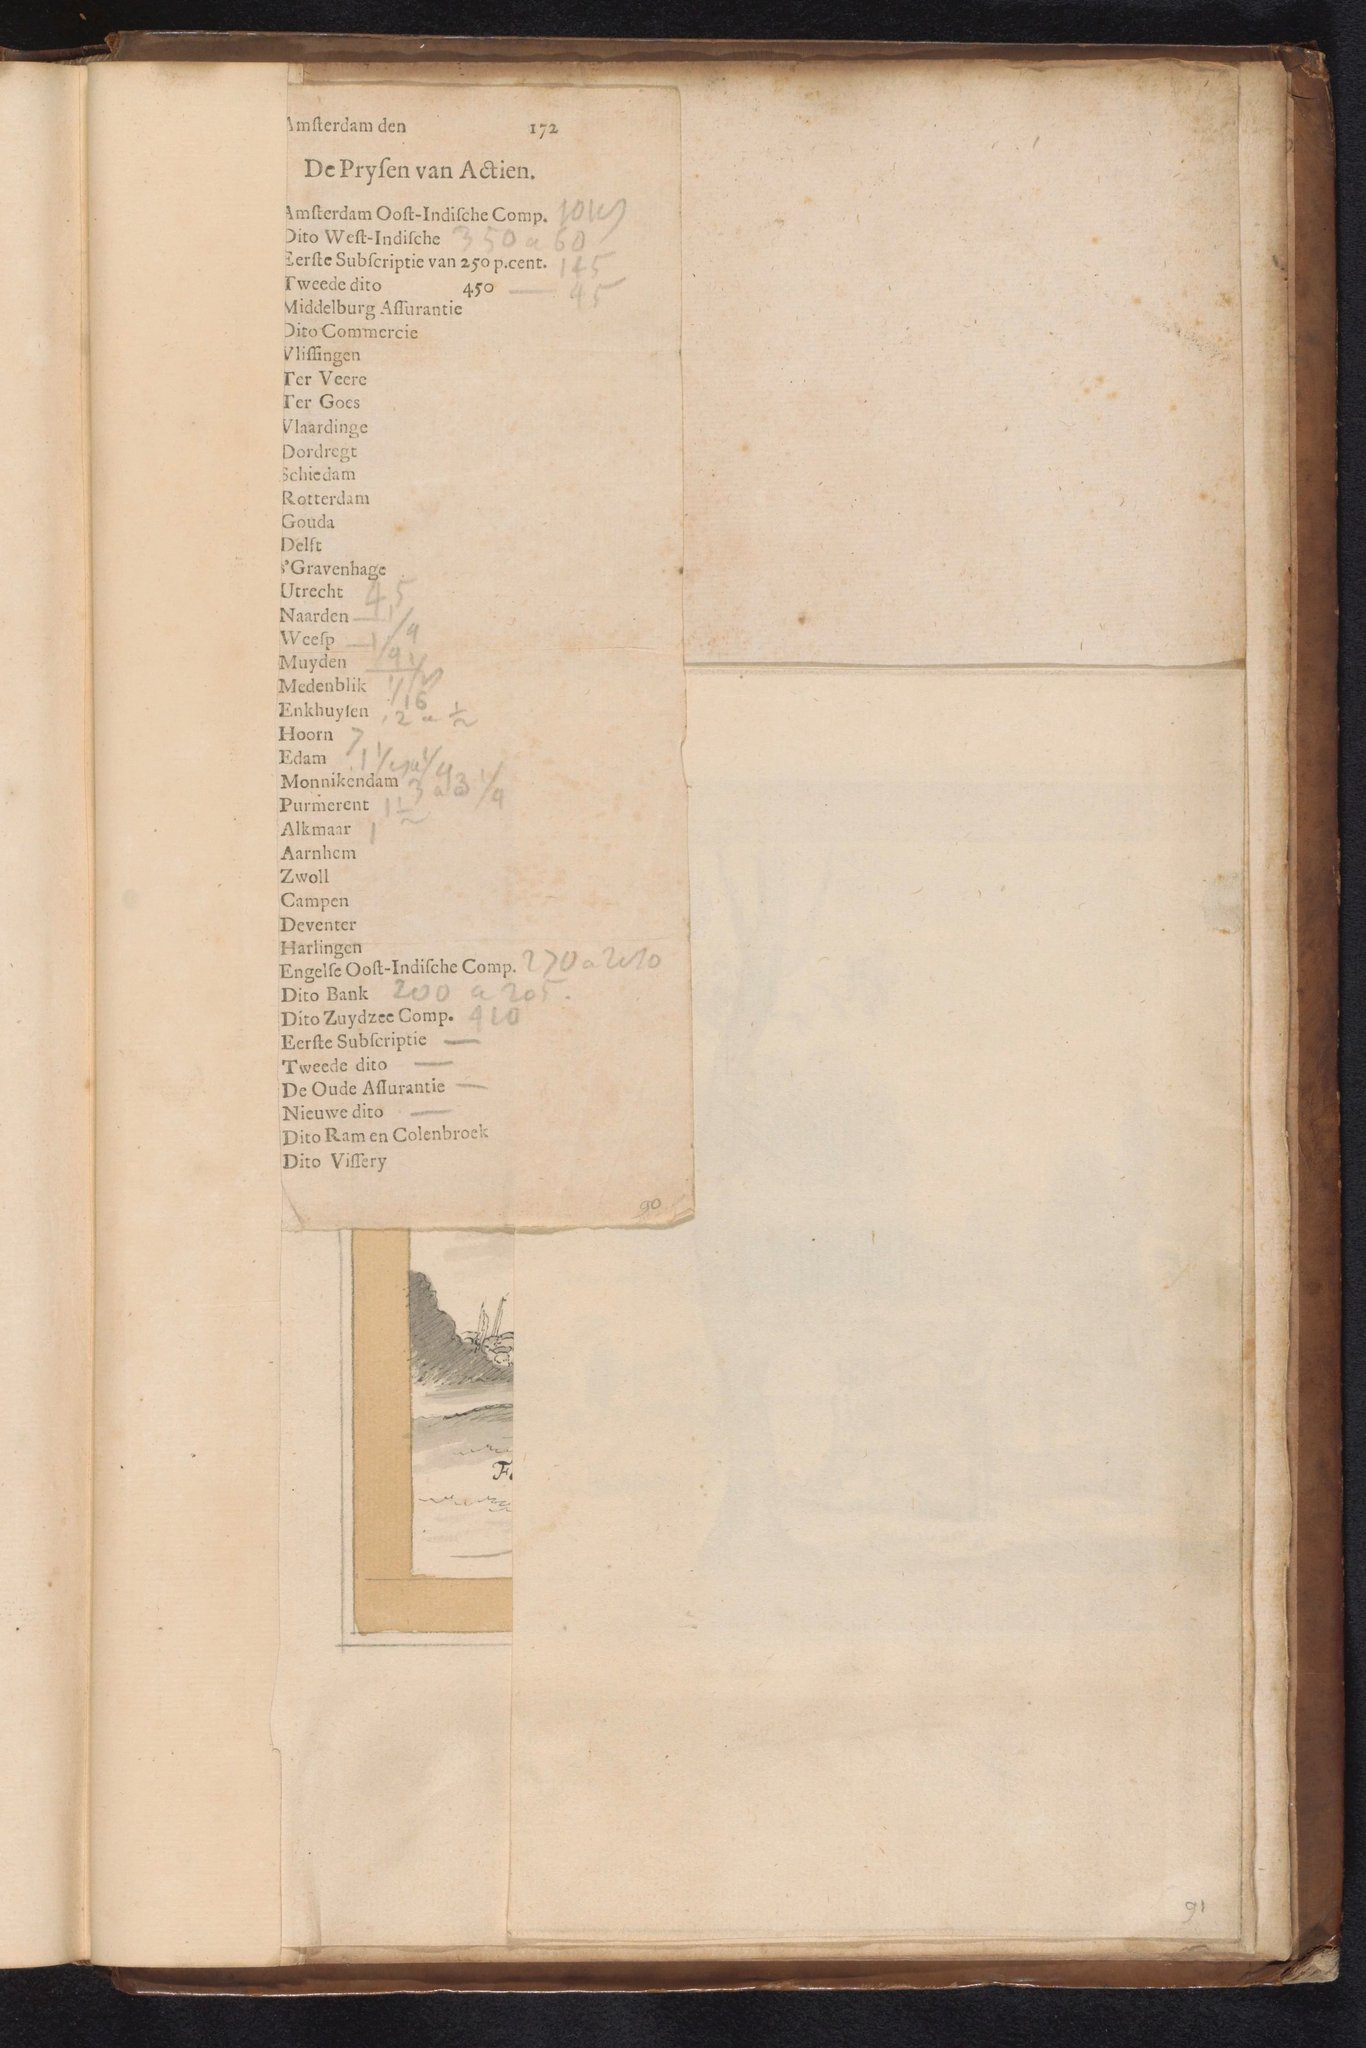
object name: document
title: Het Groote Tafereel der Dwaasheid (extra stukken)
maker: Anonymous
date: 1720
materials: paper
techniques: letterpress printing, writing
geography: northern netherlands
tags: beurs van hendrik de keyser, windhandel van 1720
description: Koersbriefje met de prijzen van de aandelen van de oude en nieuwe compagnieën verhandeld op de Beurs te Amsterdam, 1720. Achter de namen van verschillende compagnieën zijn met potlood bedragen geschreven. Behoort tot de groep van extra stukken meegebonden in de gebonden eerste uitgave (304 B 11) van Het Tafereel der Dwaasheid met spotprenten op de Windhandel of Actiehandel van 1720.